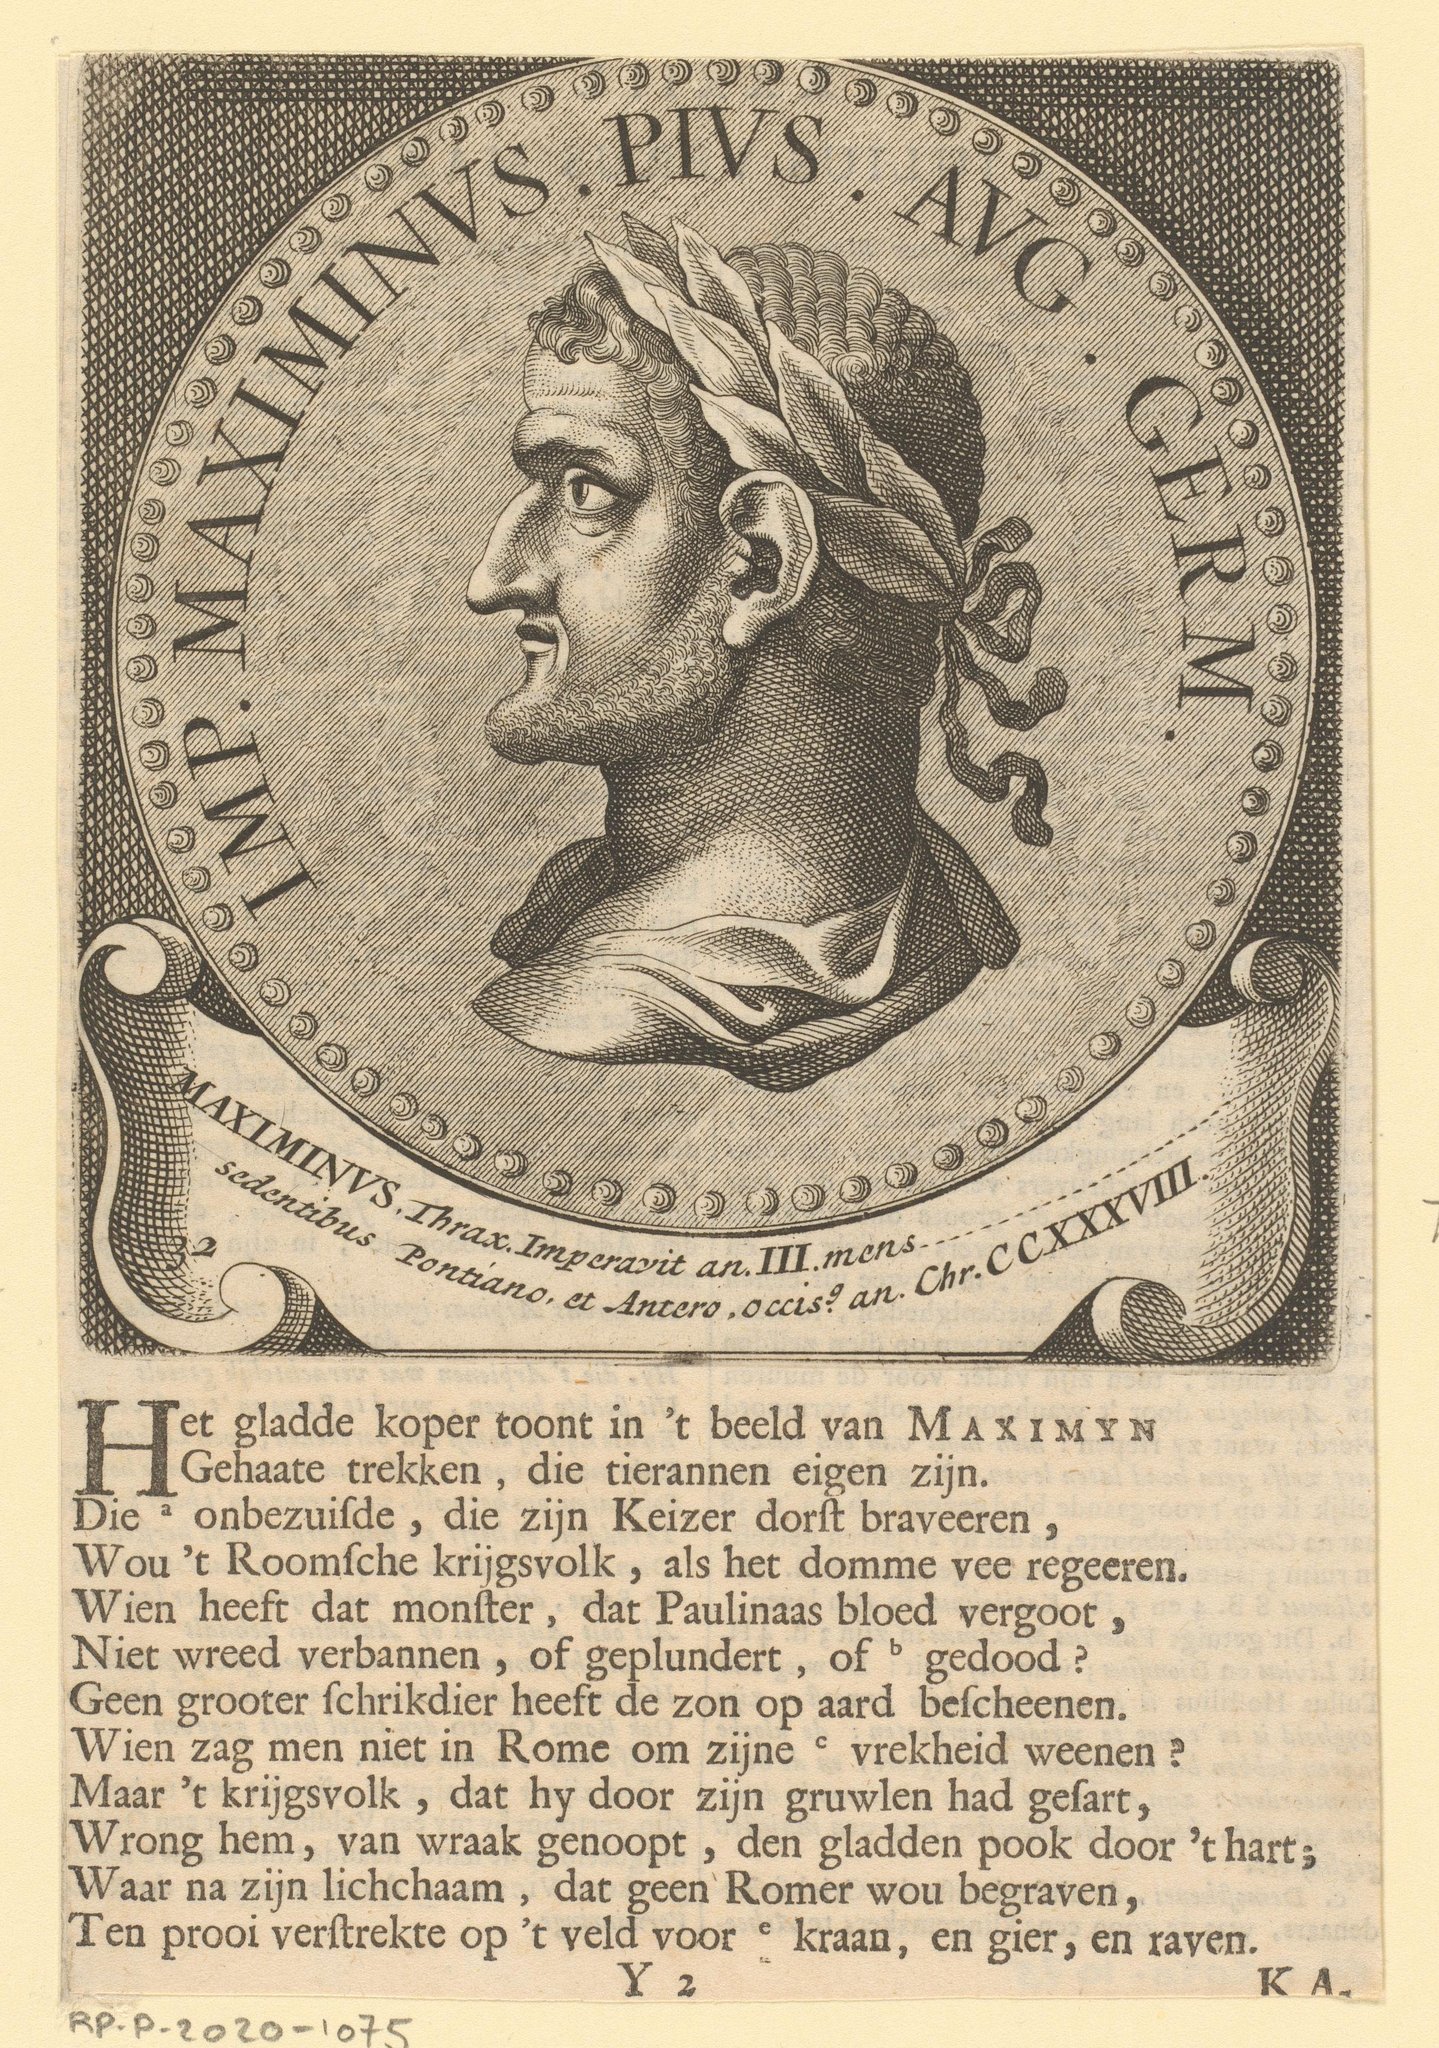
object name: print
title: Portret van keizer Maximinus I Thrax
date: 1697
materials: paper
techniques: engraving, etching, letterpress printing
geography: utrecht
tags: historical persons, emperor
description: Prent uit: Bogaert, Abraham. De Roomsche monarchy, vertoont in de muntbeelden der westersche en oostersche keizeren (...). Utrecht: François Halma en Willem van de Water, 1697, p. 171. Eerste staat verschenen in een grotere prent met twaalf portretten, gedateerd 1695.